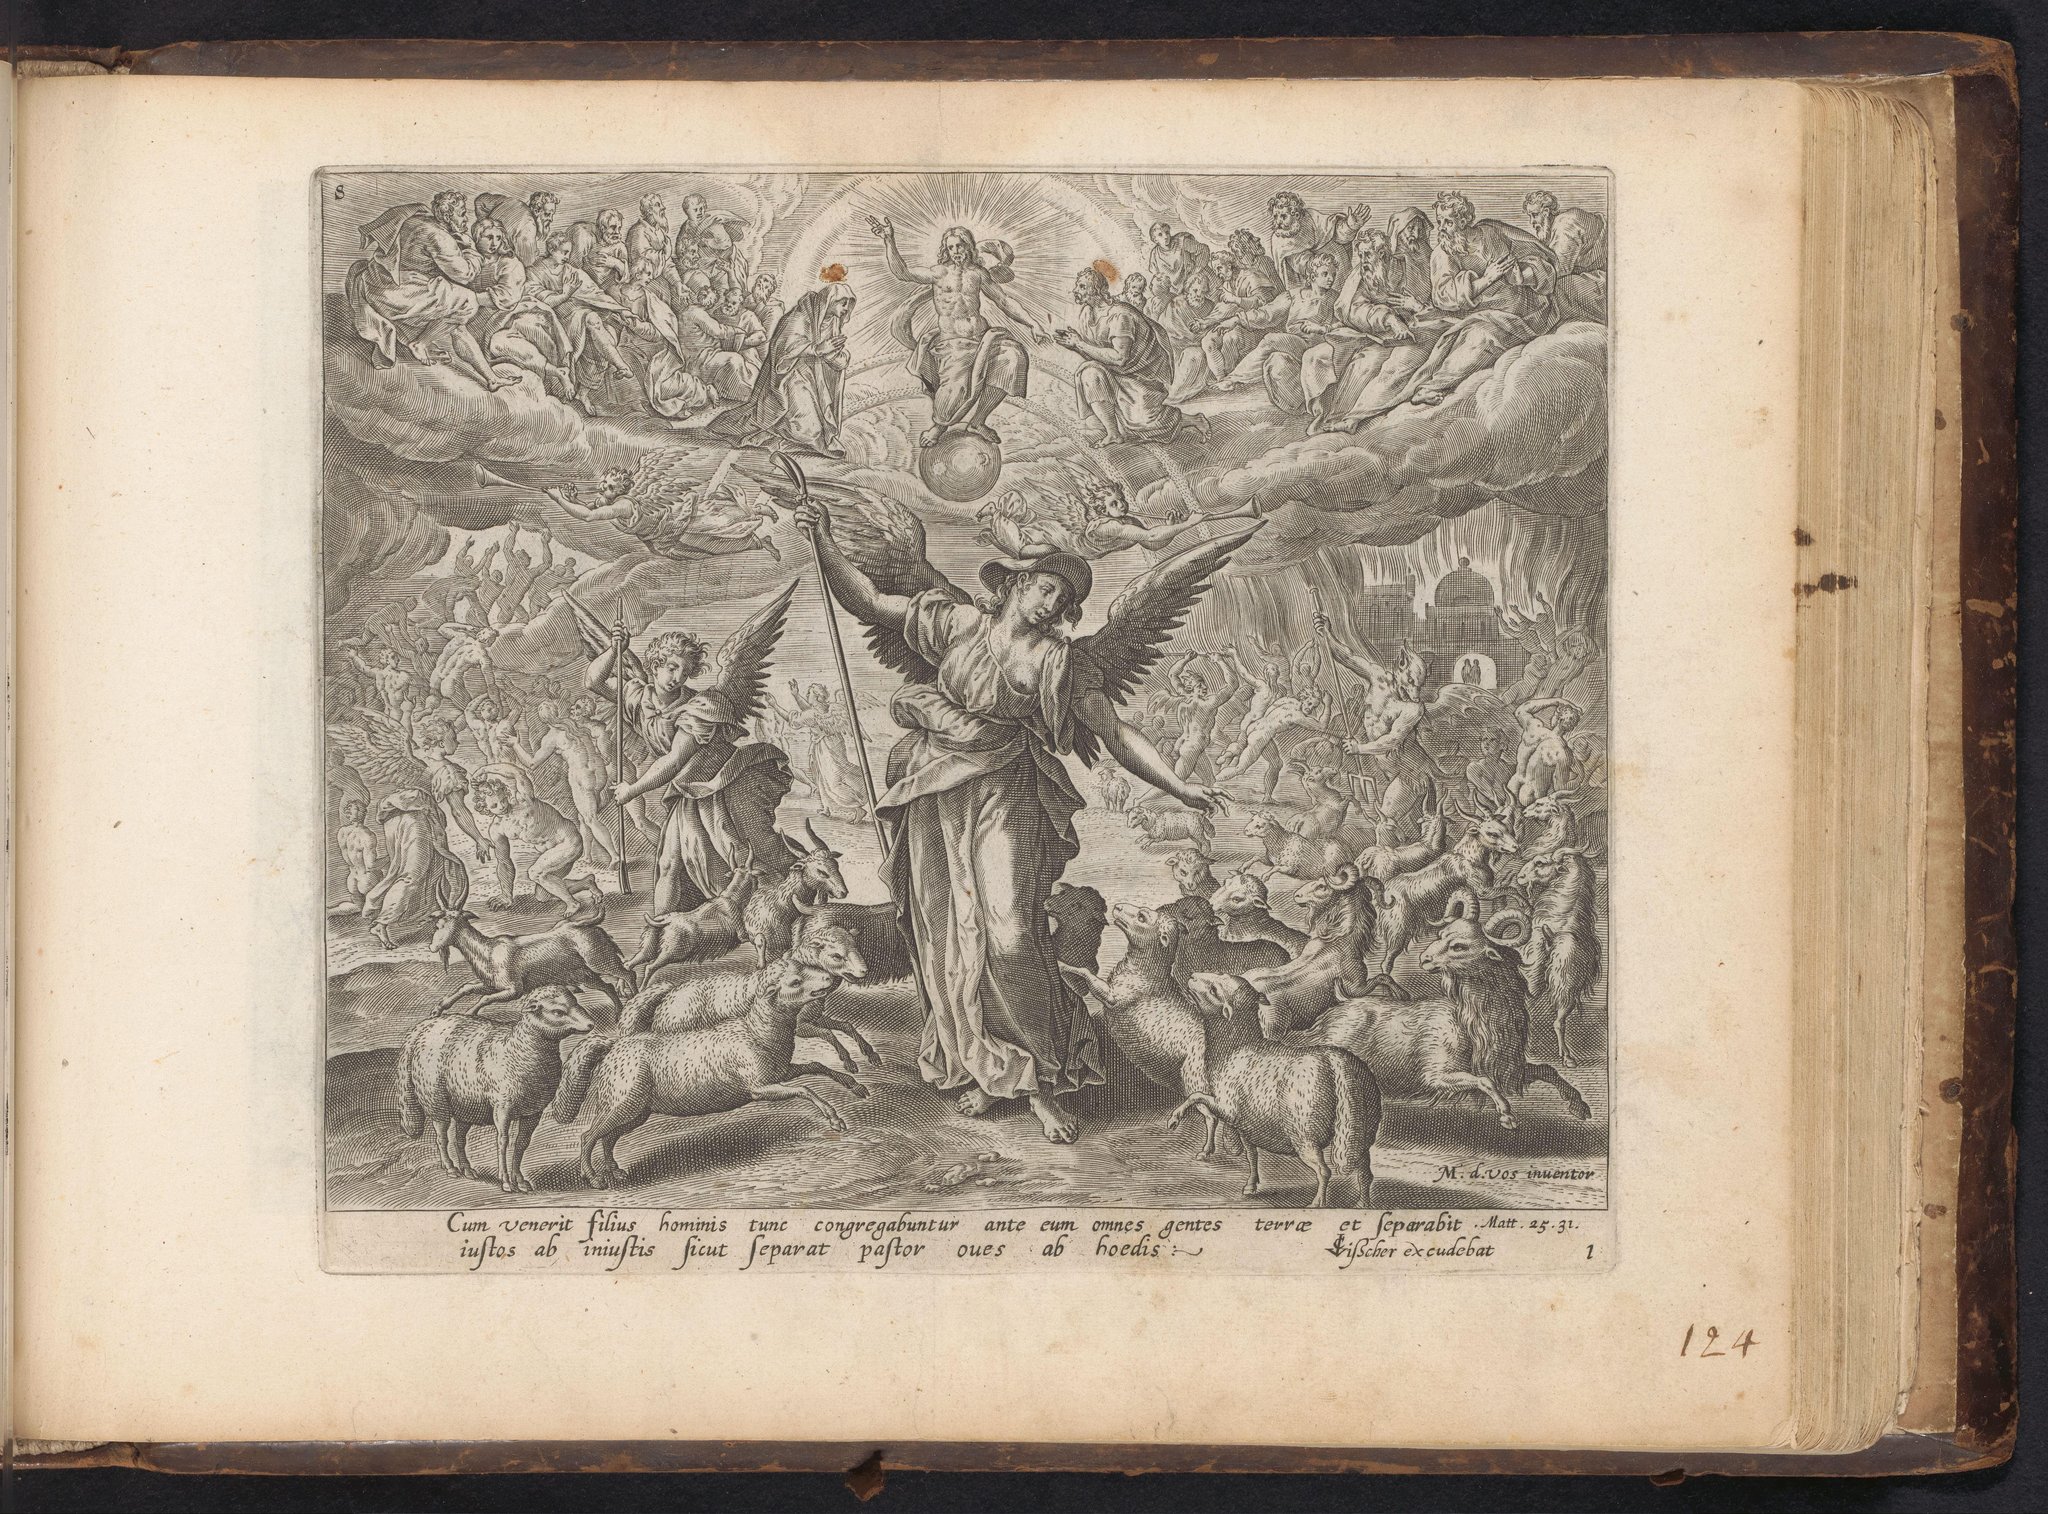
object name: album leaf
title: Van de Wercken der Barmherticheyt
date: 1585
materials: paper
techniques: engraving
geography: alkmaar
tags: 'as a shepherd (the son of man) separates the sheep from the goats' (matthew 25:32), representation of last judgement, with the archangel michael weighing the souls (or dividing the blessed and the damned)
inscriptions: number: ‘124’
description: De aartsengel Michael scheidt de schapen van de bokken. Christus troont op de wolken, geflankeerd door Maria en Johannes. De doden worden door engelen naar de hemel geleid (links) of naar de hel gevoerd (rechts). Onder de voorstelling een verwijzing in het Latijn naar de Bijbeltekst in Mat. 25:31. Deze prent maakt deel uit van een album.